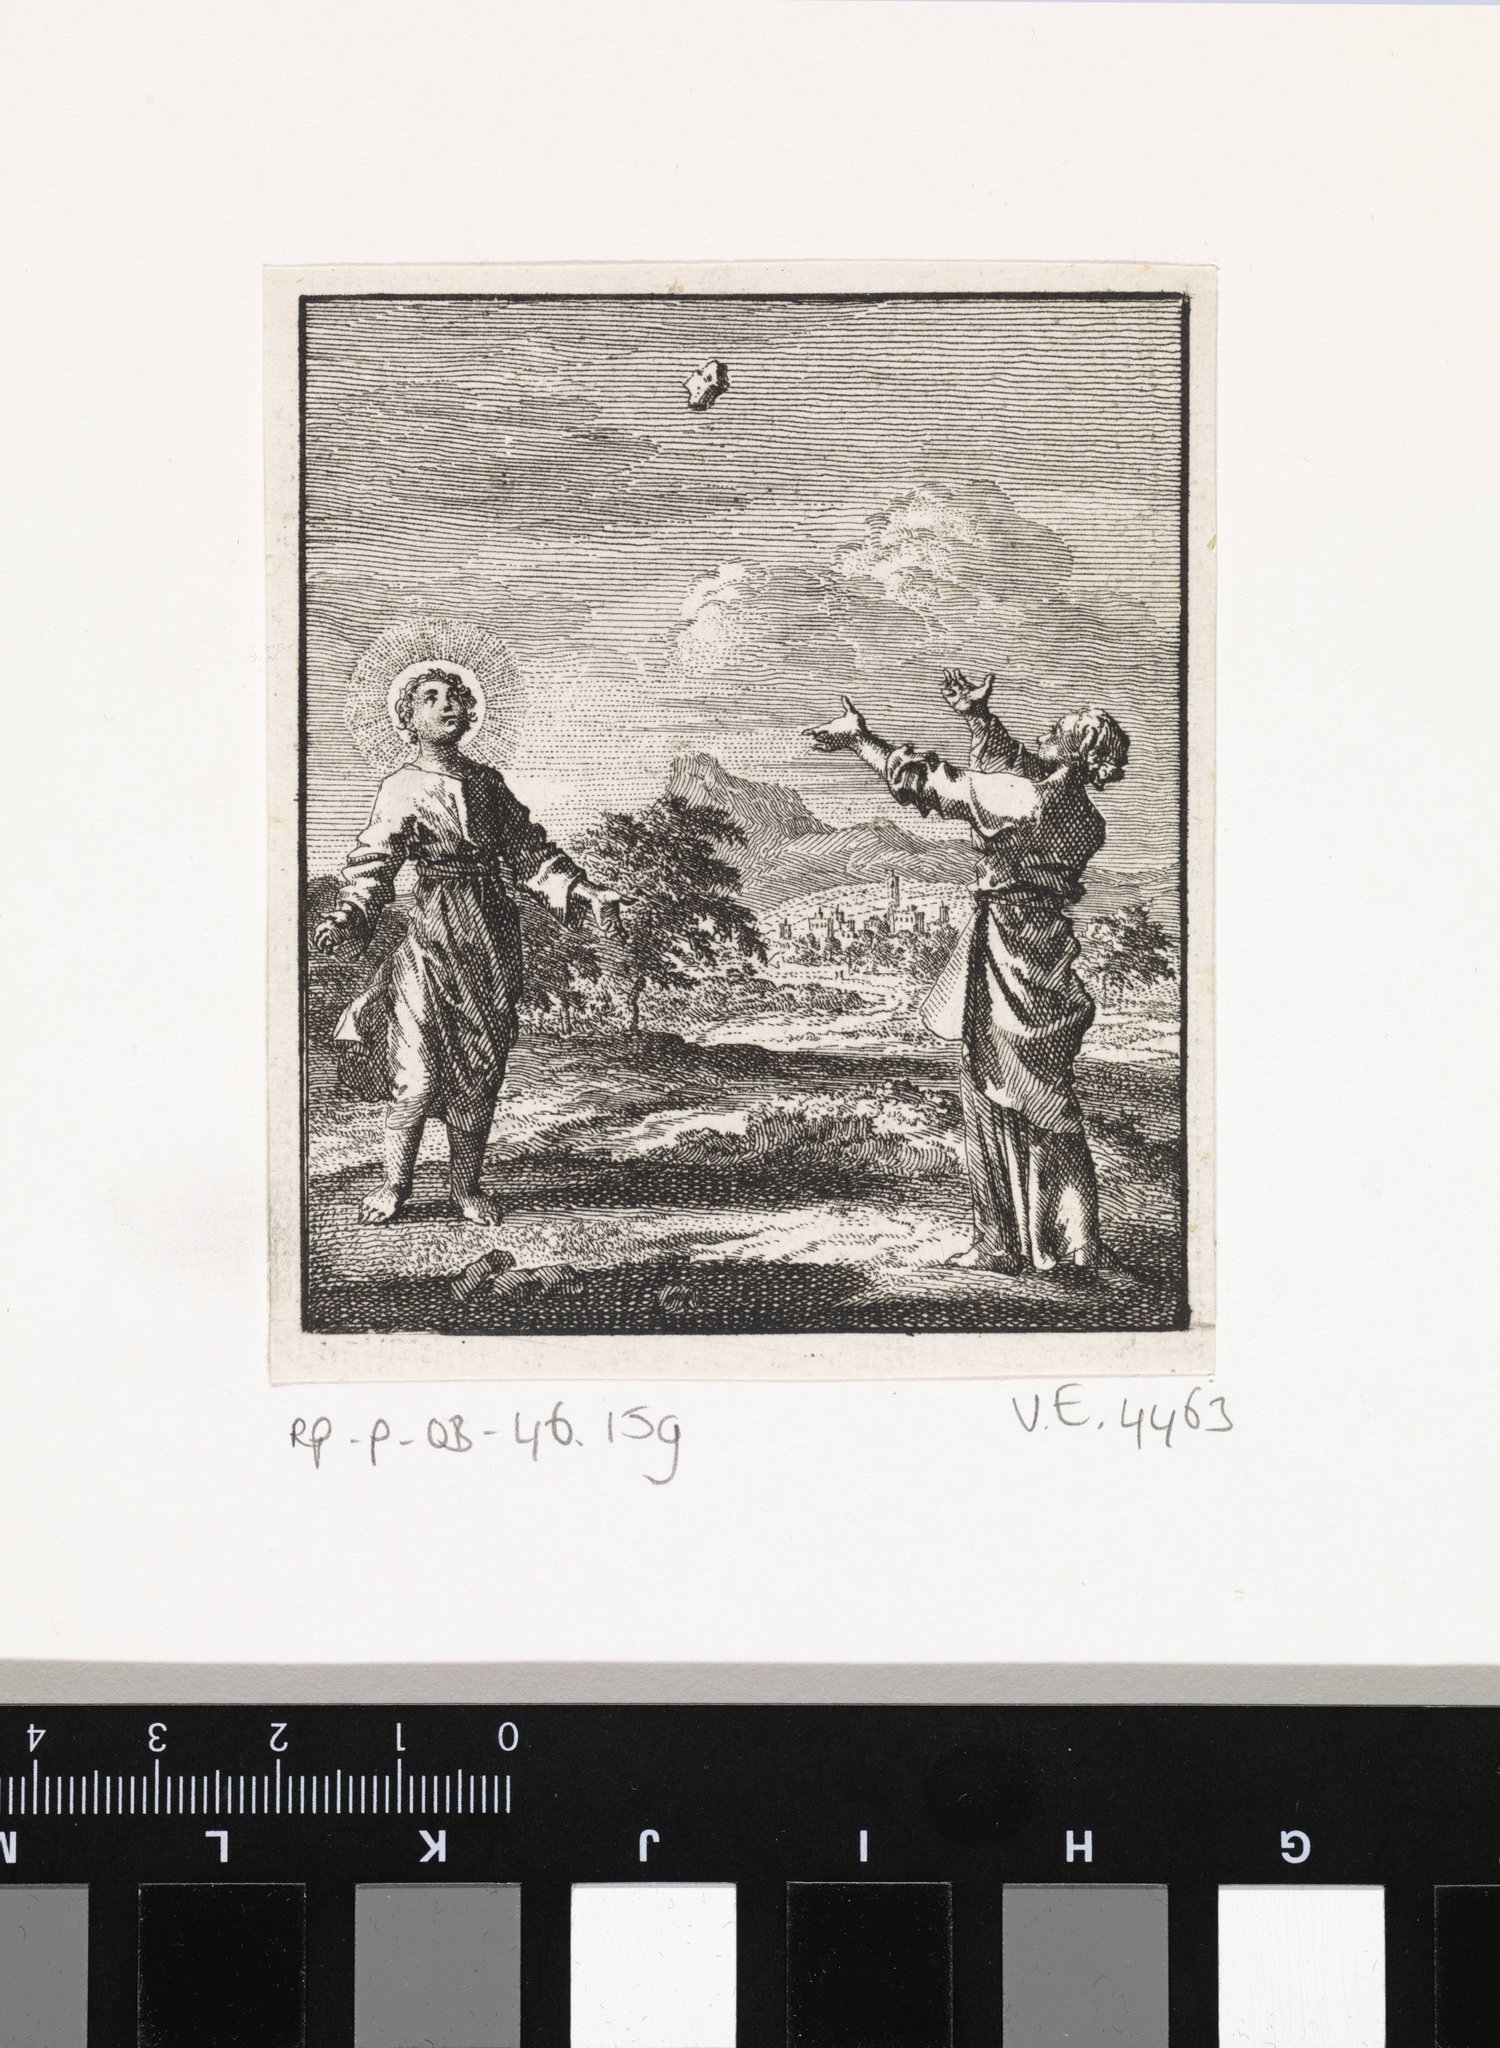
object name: print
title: Christus en de gepersonifieerde ziel aanschouwen een vallende steen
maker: jan luyken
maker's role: draughtsman, print maker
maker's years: 1649-1712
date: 1714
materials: paper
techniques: etching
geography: amsterdam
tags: smith, blacksmith (+ place ~ crafts, industries, agriculture)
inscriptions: collector's mark: Lugt 2228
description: Proefdruk van illustratie uit: Luyken, Jan. Jezus en de Ziel, 3 delen. Amsterdam: Wed. Pieter Arentsz II en Cornelis van der Sys, 1714, dl. II, p. 101.